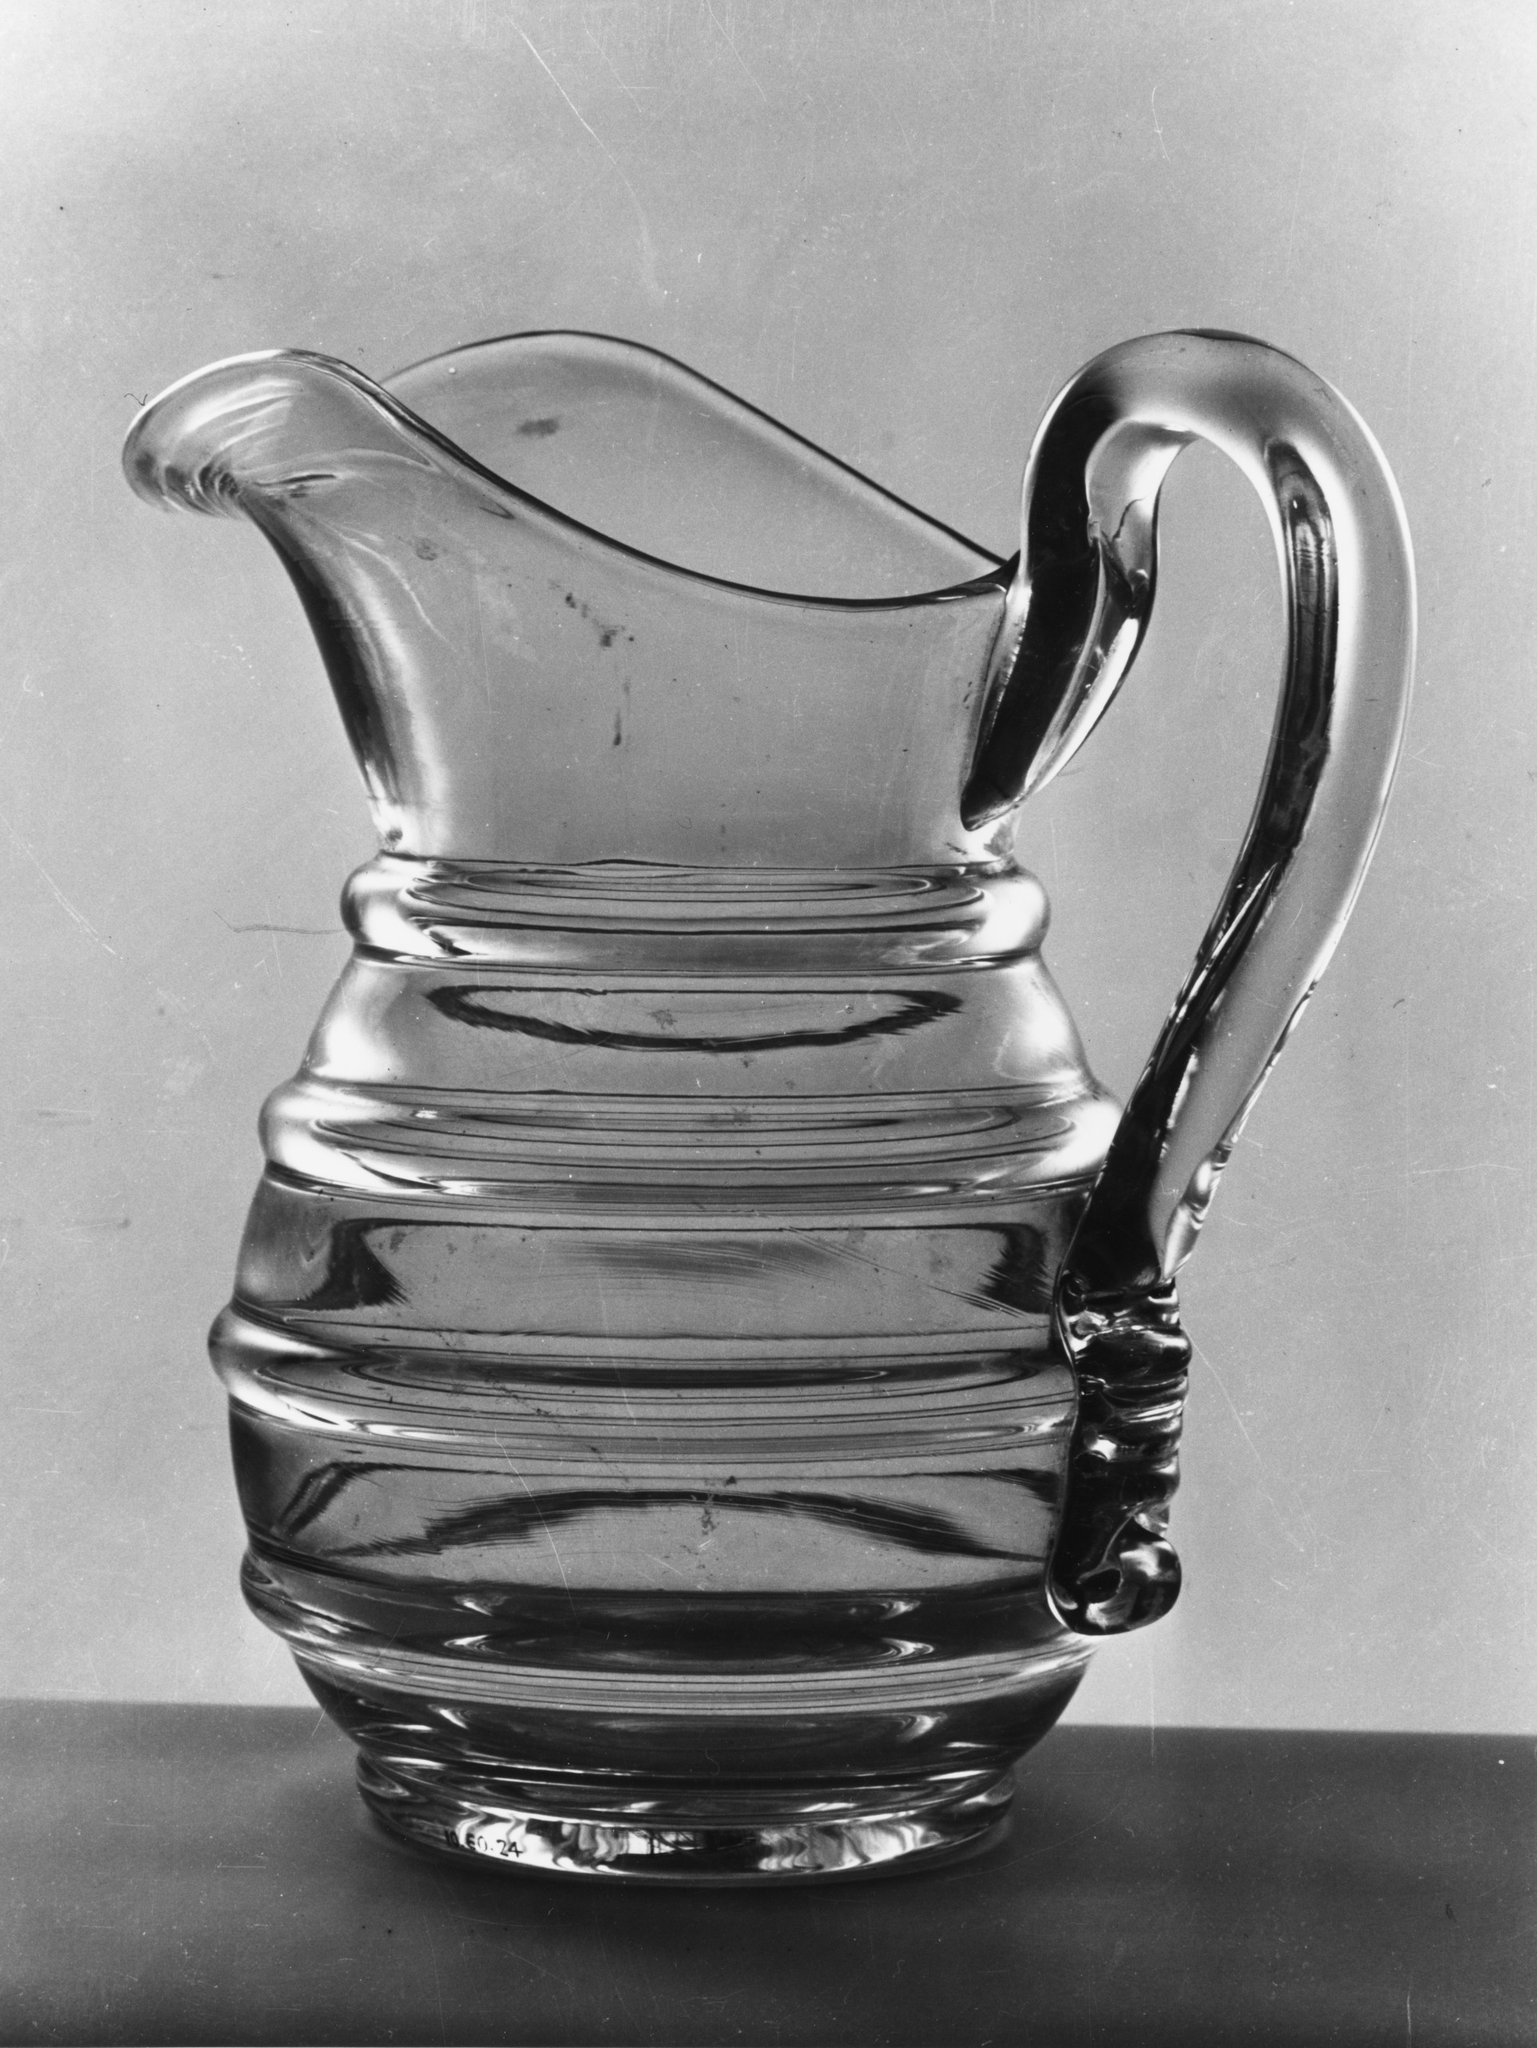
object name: pitcher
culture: american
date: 1830-1870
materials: glass, lead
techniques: glassblowing, molding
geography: united states